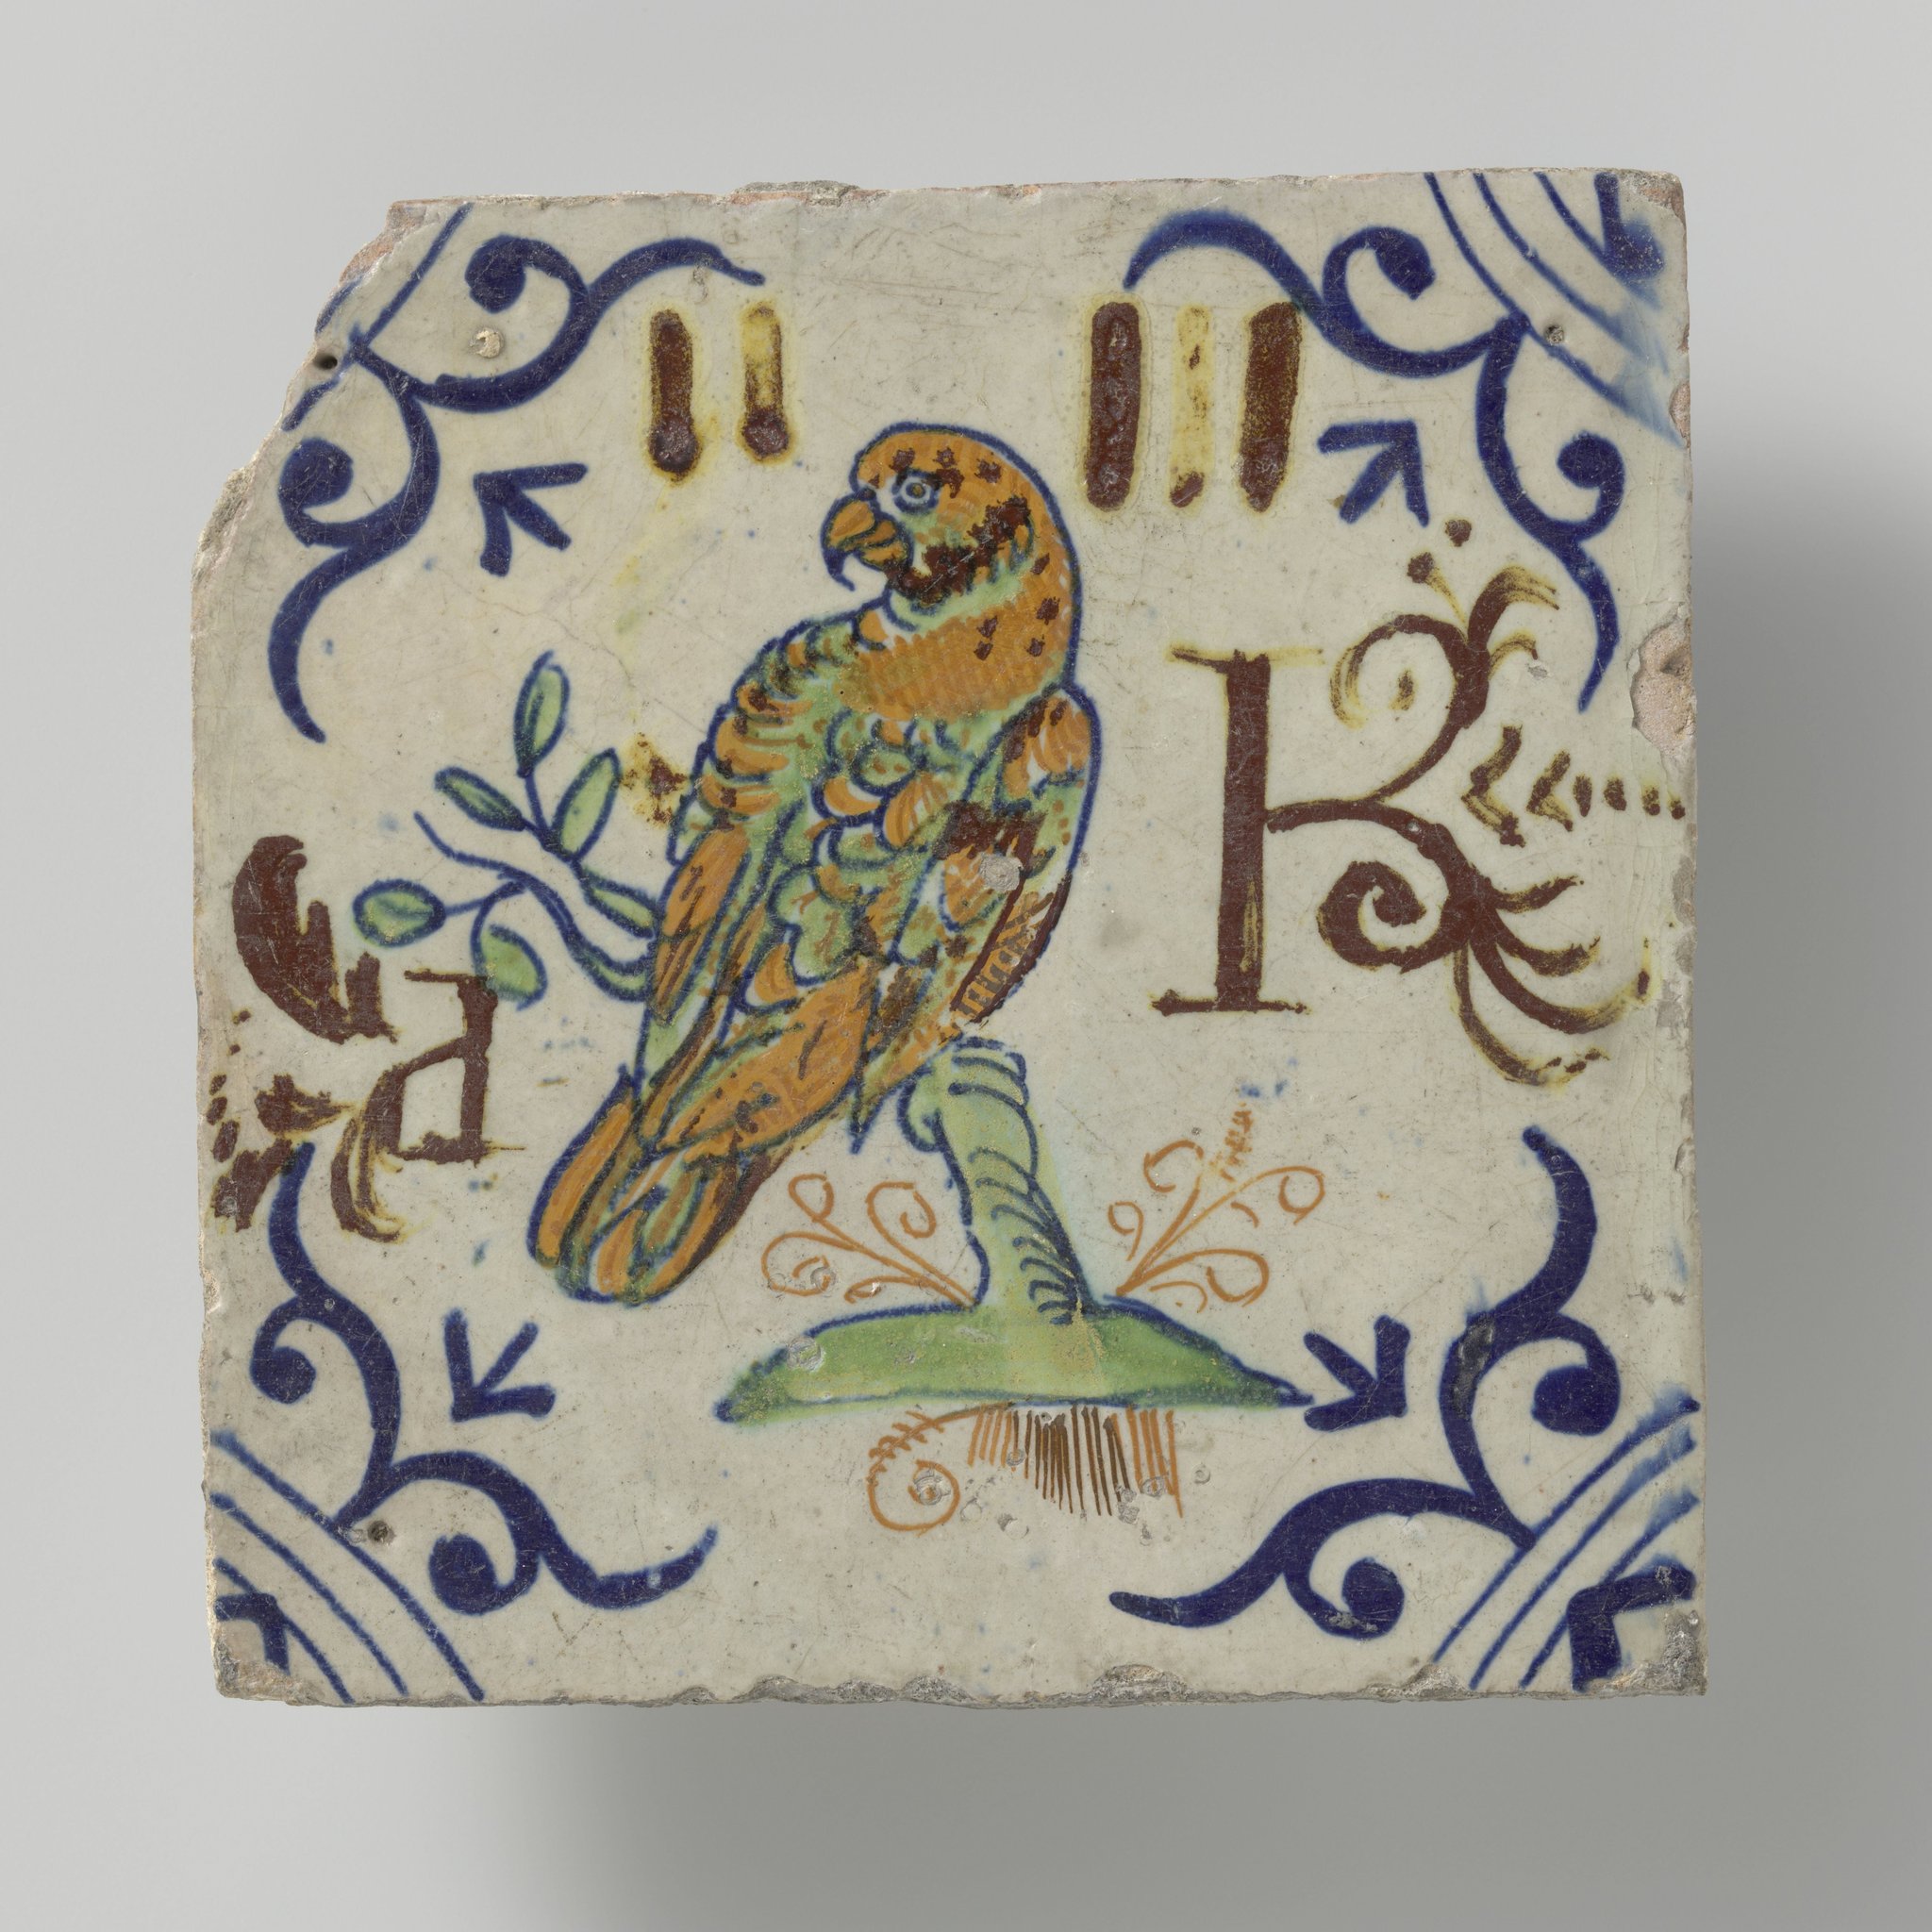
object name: vogeltegel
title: Tegel met papegaai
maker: Anonymous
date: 1635-1670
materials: earthenware, glaze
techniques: maiolica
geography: netherlands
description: Tegel met een veelkleurig (blauw, groen, geel, oranje en bruinrood) geschilderde papegaai op een tak. Aan weerskanten de letters: P en K (?). In de hoeken, een ossenkop.